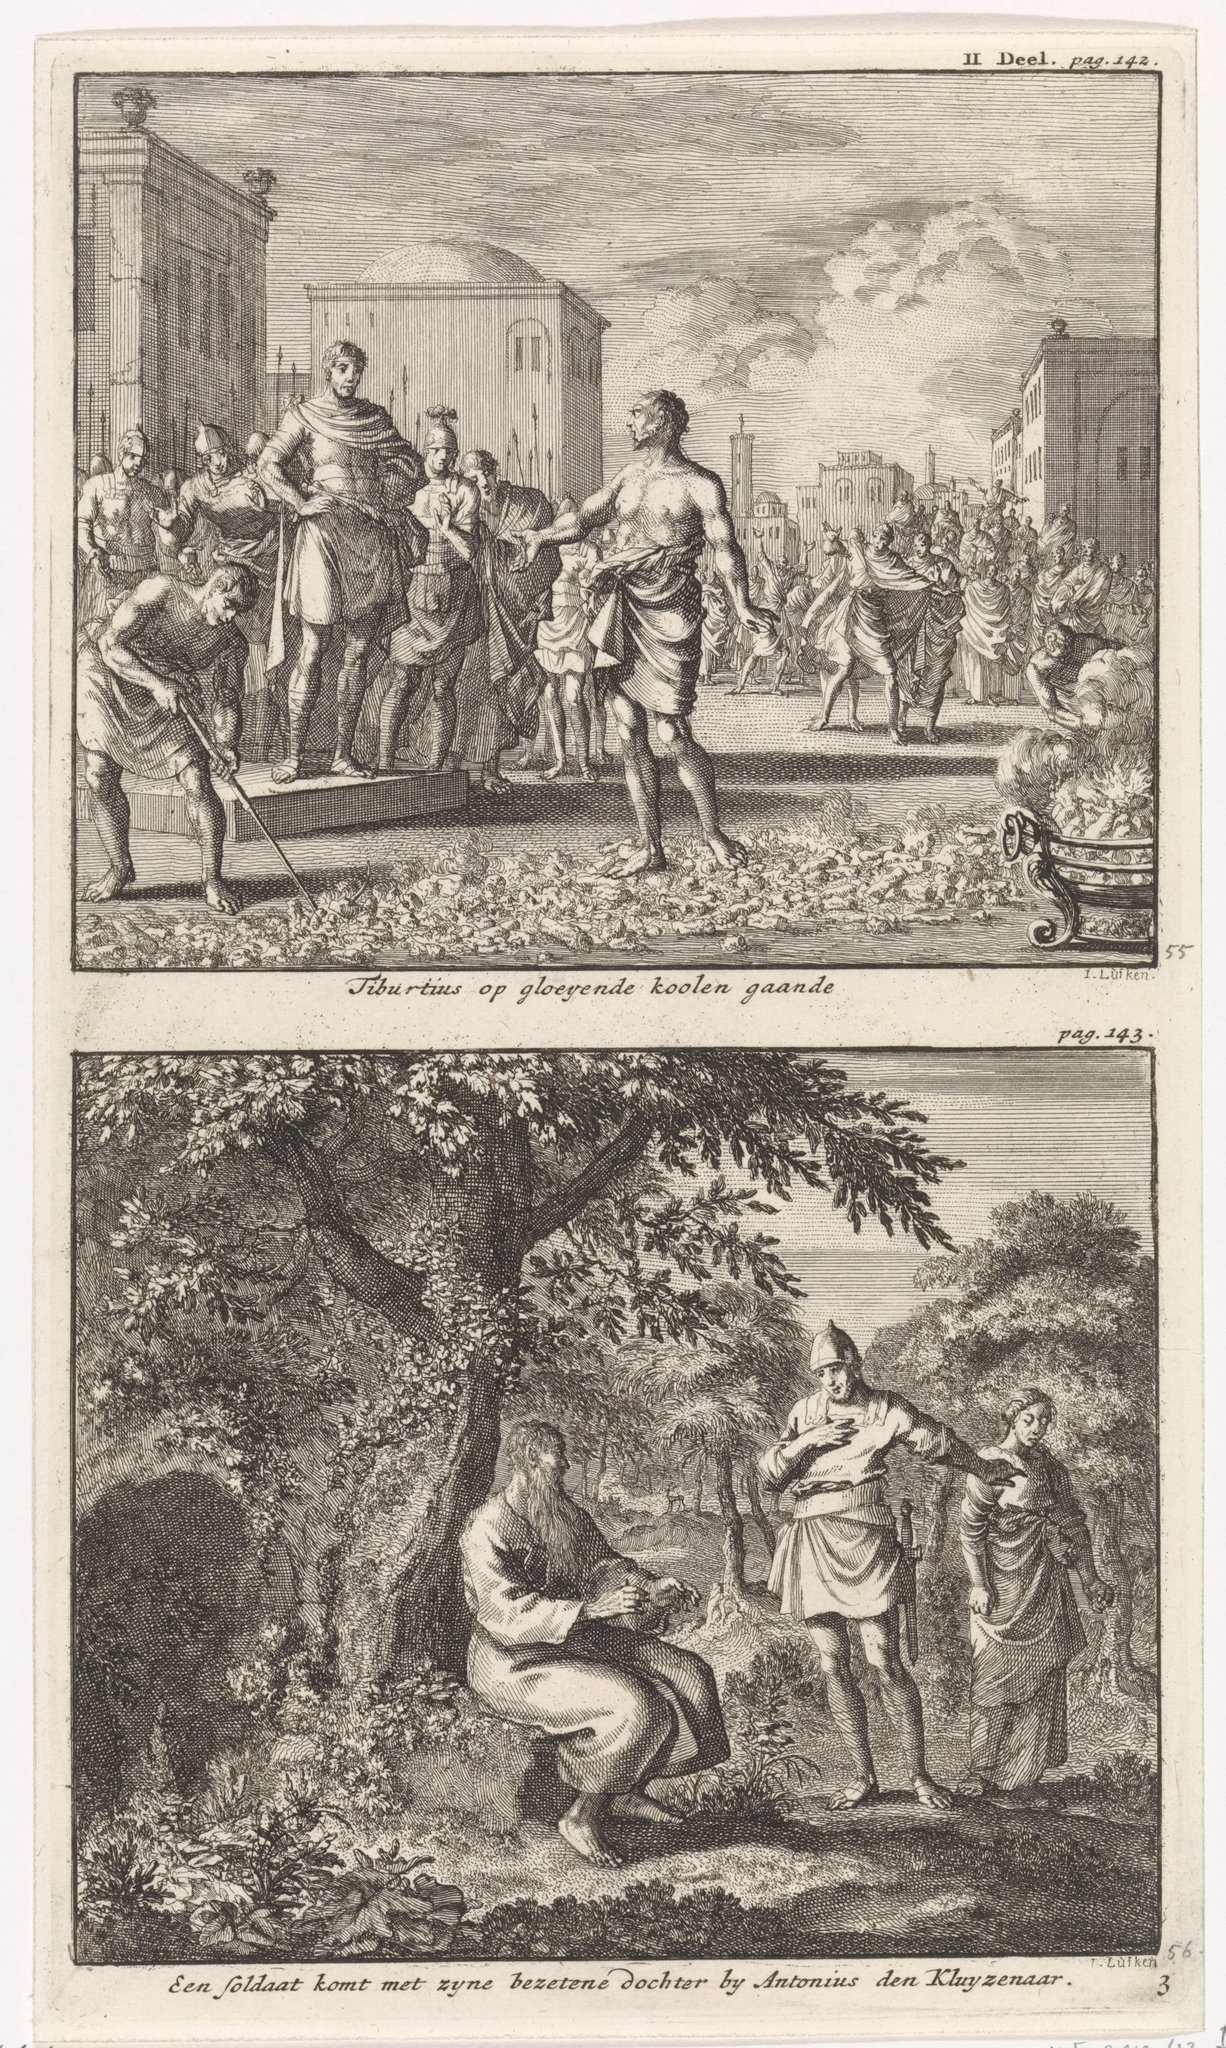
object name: print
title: Tiburtius op gloeyende koolen gaande / Een soldaat komt by Antonius den Kluyzenaar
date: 1701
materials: paper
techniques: etching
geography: amsterdam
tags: the early christian churches, e.g. armenians, copts, syrians, violent death by heat (boiling lead, burning coal, etc.) - ee - death not certain; wounded person, burning as process: coal, male saints (with name) - martyrdom, suffering, misfortune, death of male saint, the hermit antony abbot (antonius abbas) of egypt, also called the great; possible attributes: bell, book, t-shaped staff, flames, pig - miraculous activities and events ~ male saint, possession (by demons) - aa - female human figure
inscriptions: collector's mark: Lugt 2228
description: Twee voorstellingen op een plaat. Boven: de H. Tiburtius van Rome wandelt over hete kolen terwijl een rechter aanspreekt die links van hem op een verhoog staat. Op de achtergrond kijken toeschouwers in ongeloof toe. Onder: de H. Antonius zit voor zijn grot in de wildernis. Rechts staat een soldaat die naar zijn dochter wijst. De soldaat hoopt dat de H. Antonius zijn door duivels bezeten dochter kan genezen.